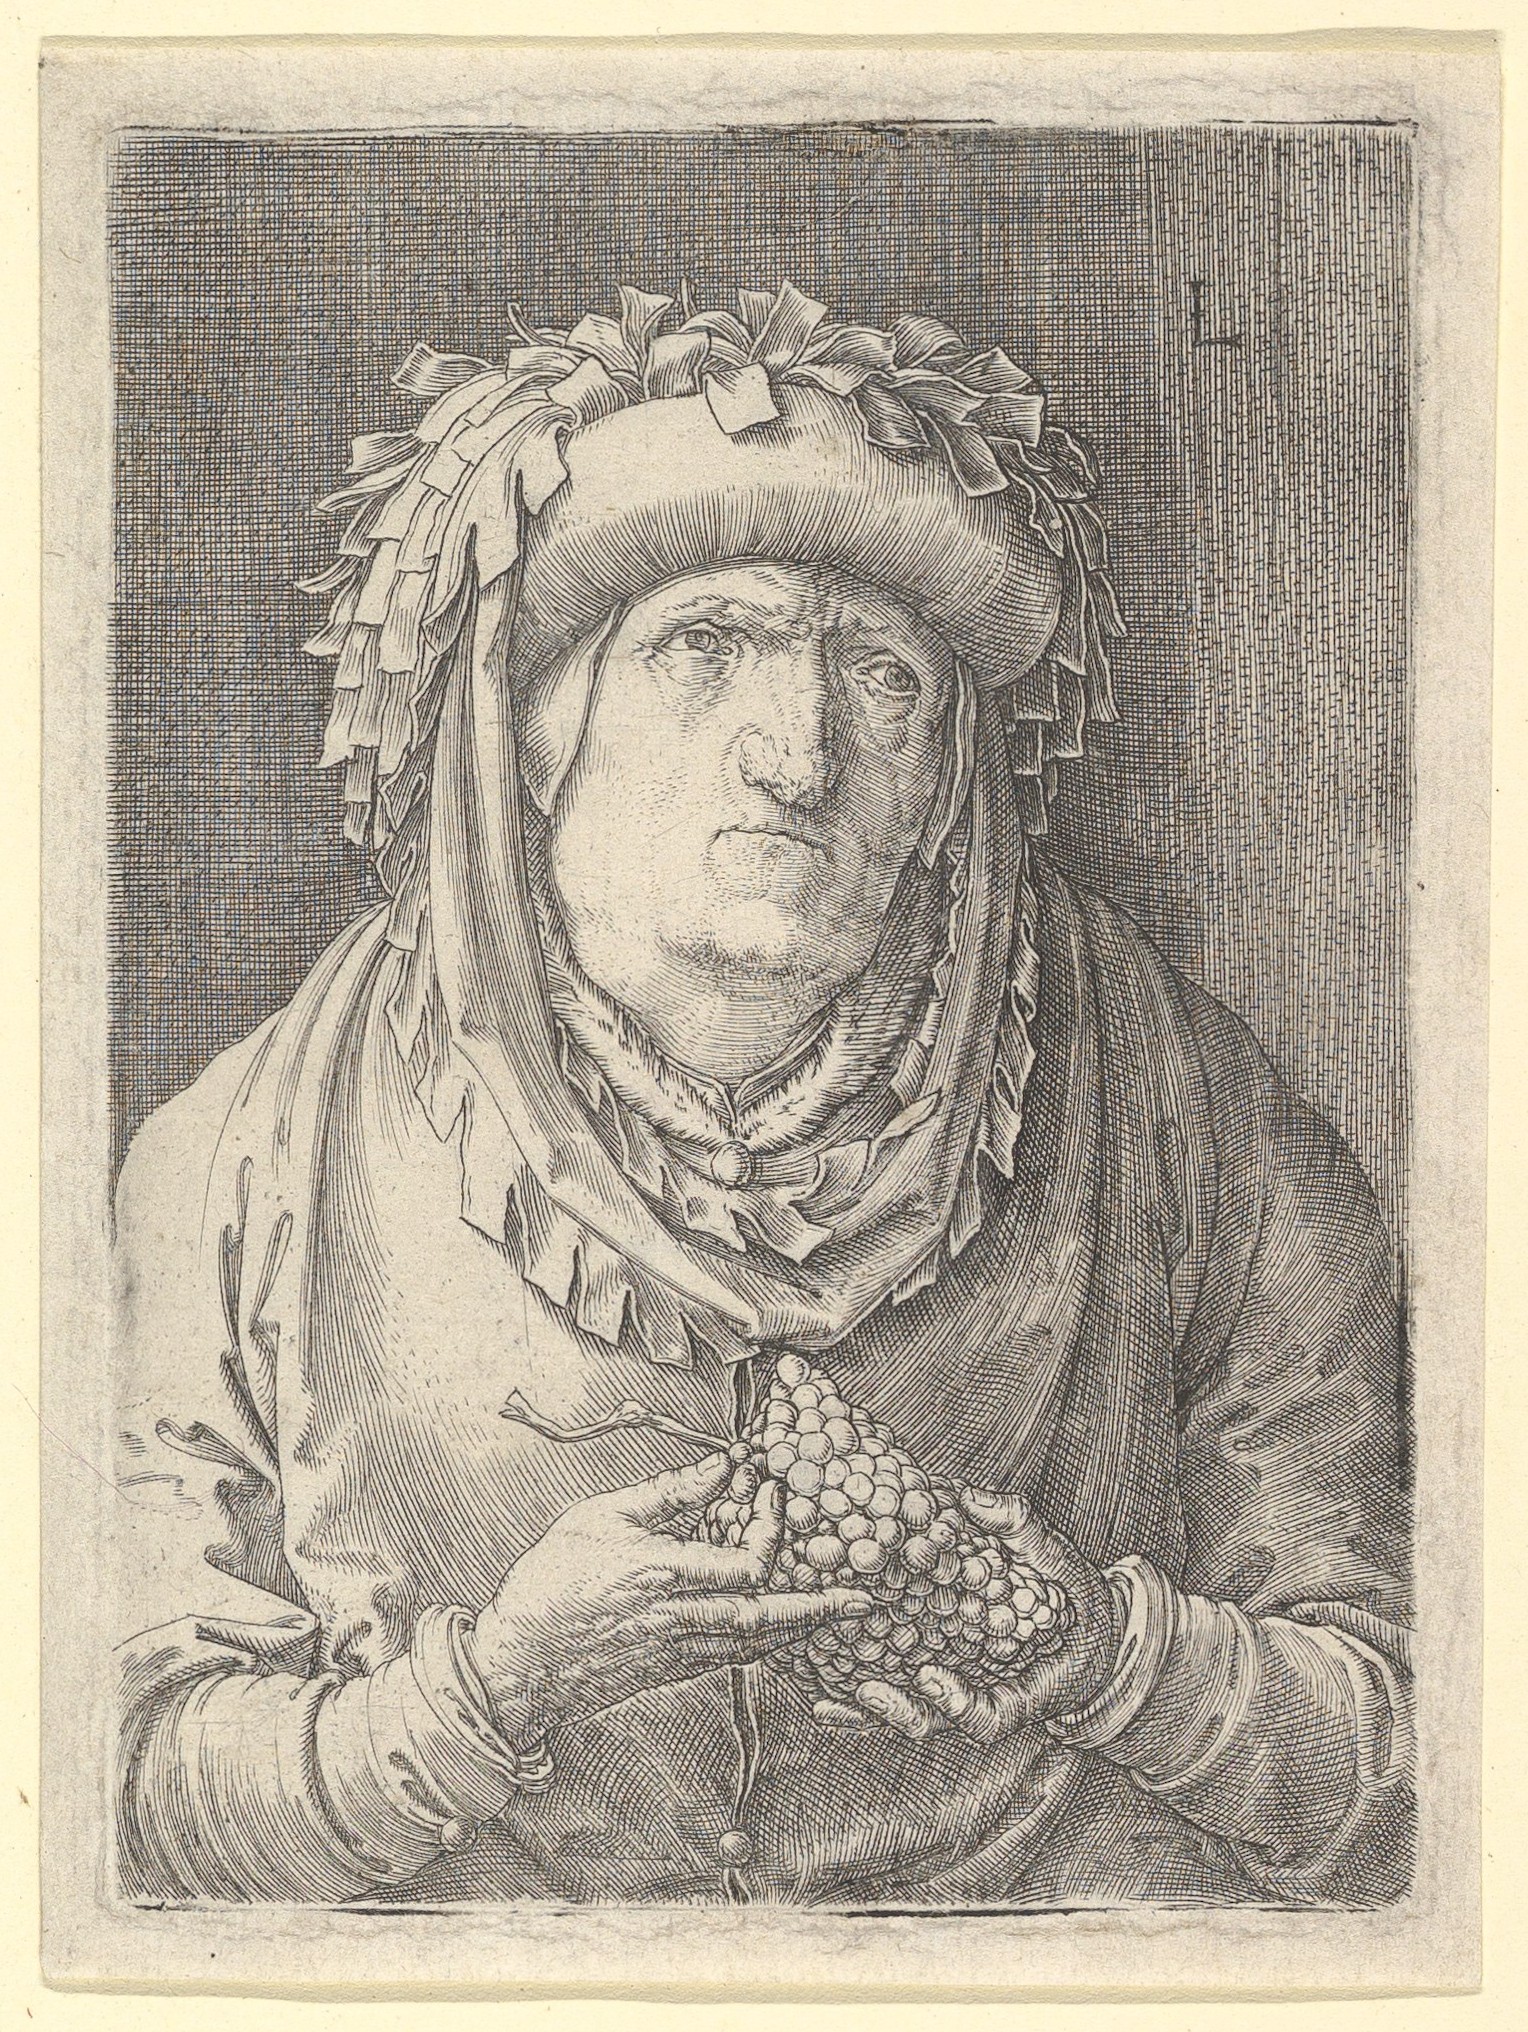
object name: print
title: Old Woman With Grapes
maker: lucas van leyden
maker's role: artist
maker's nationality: netherlandish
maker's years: 1494-1533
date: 1523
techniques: engraving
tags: grapes,women